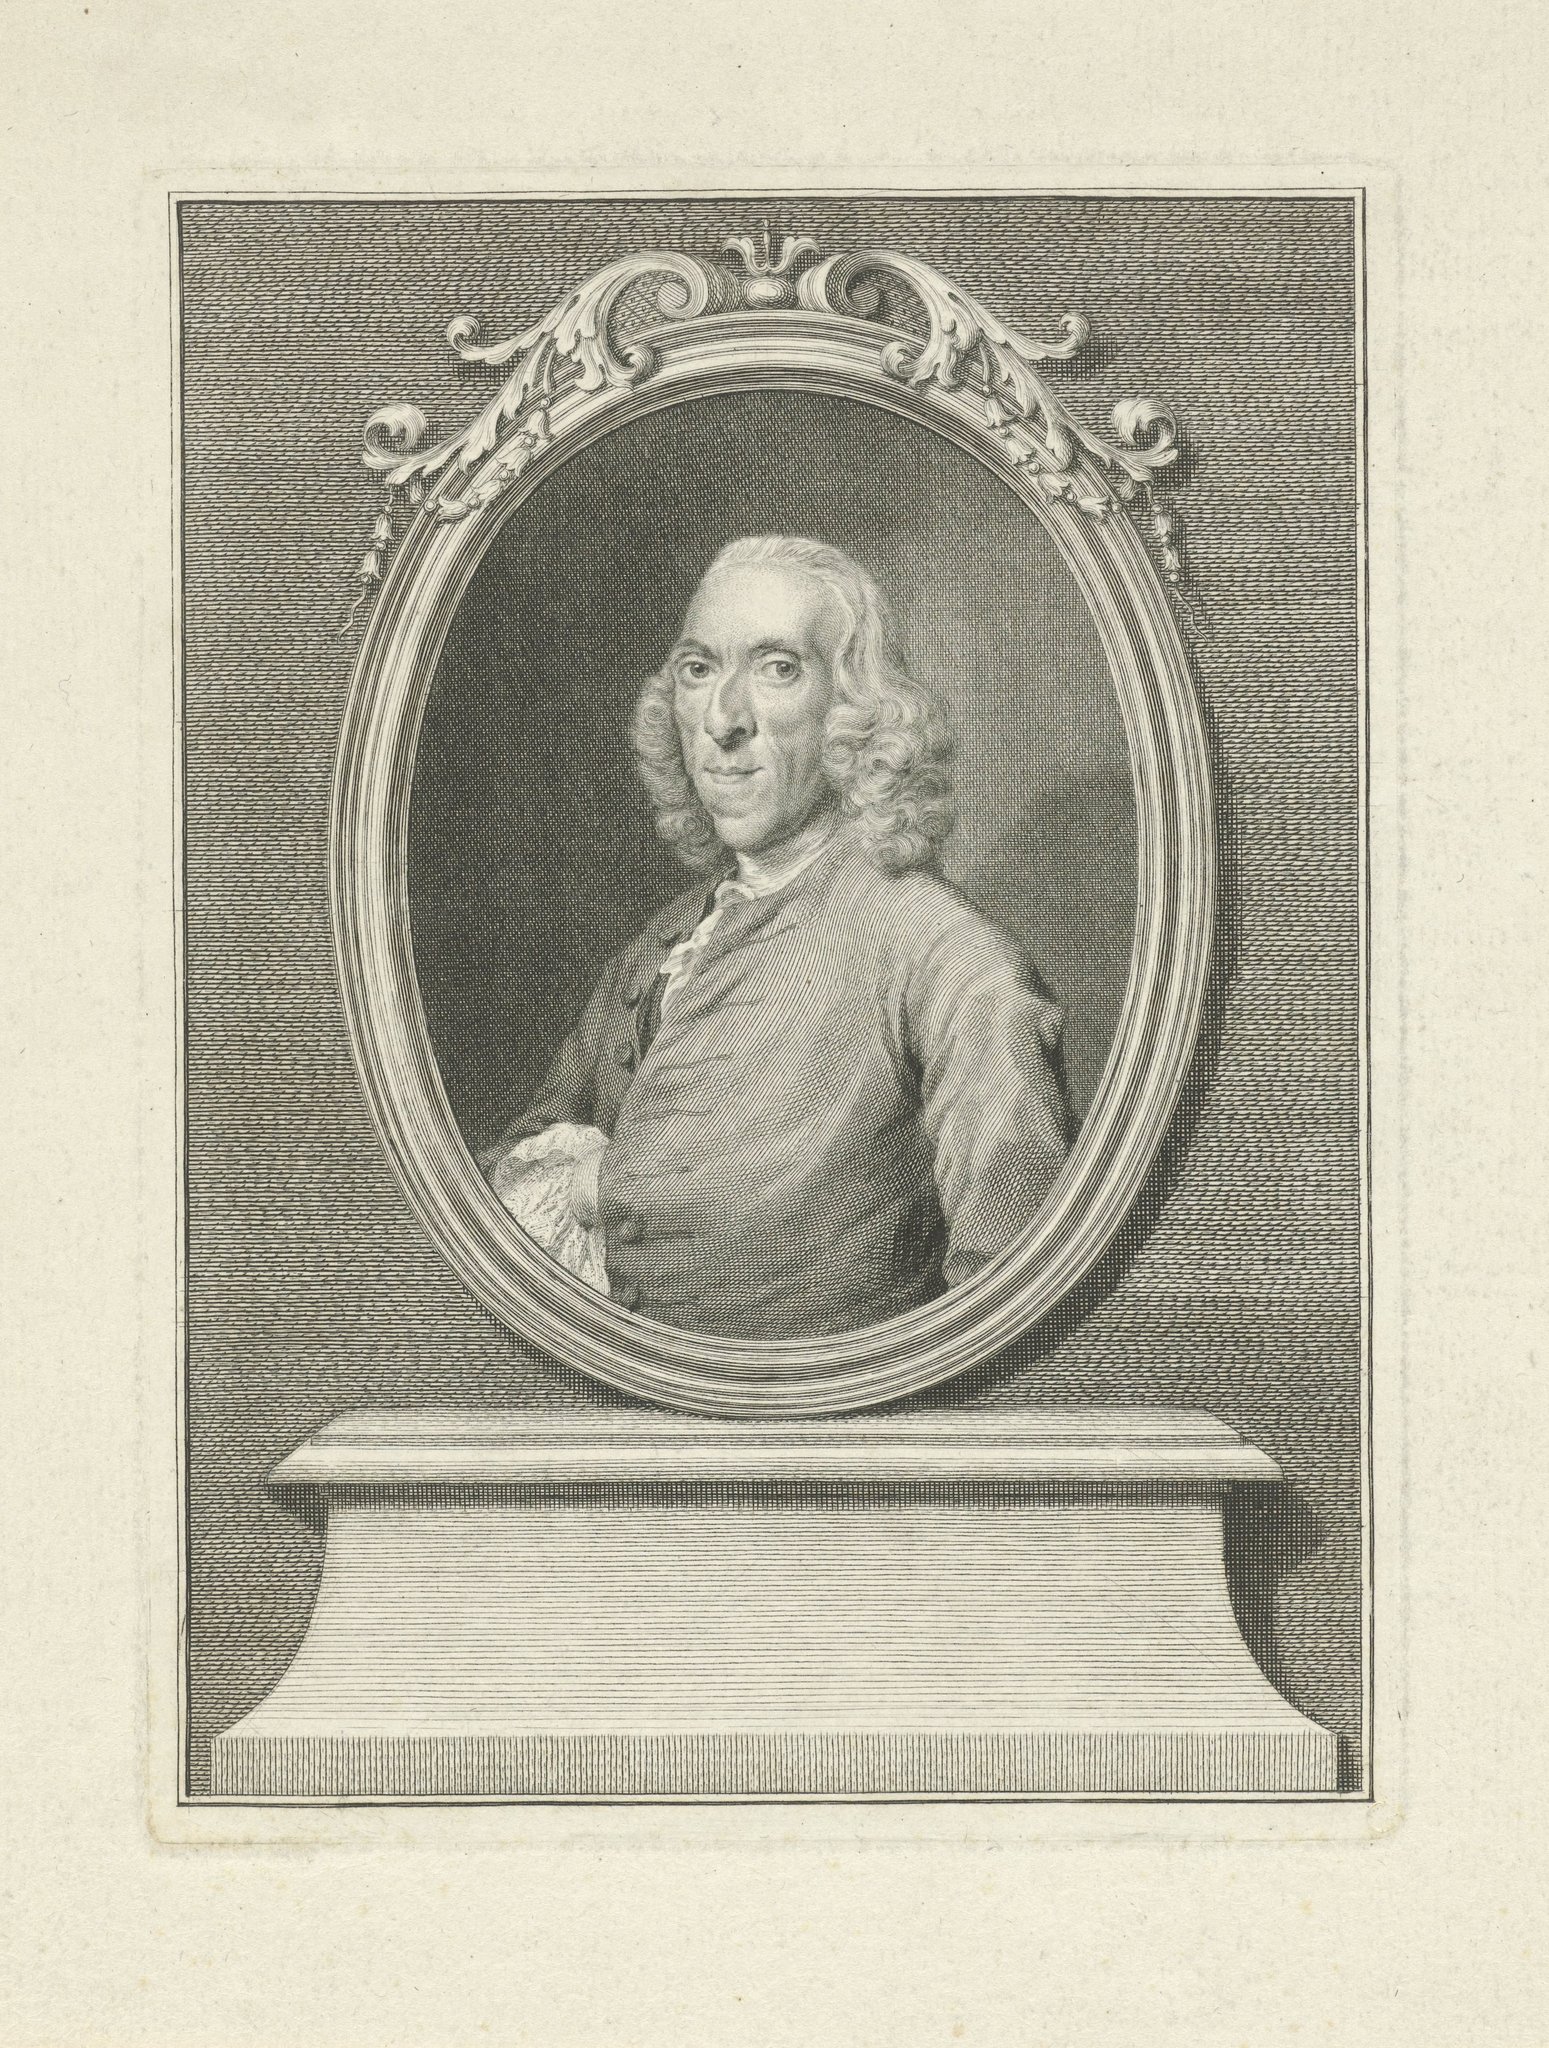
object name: print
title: Portret van Frans de Haes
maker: jacob houbraken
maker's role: draughtsman, print maker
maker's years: 1698-1780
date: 1757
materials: paper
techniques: engraving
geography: amsterdam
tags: rotterdam, frans de haes, historical persons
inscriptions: collector's mark: Lugt 2228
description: Latere staat van prent ook gebruikt in: Haes, Frans de. Het verheerlykte en vernederde Portugal, begrepen in drie boeken; waar achter gevoegd is eene verzameling van verscheide gedichten. Amsterdam: Frans Houttuyn, 1758.